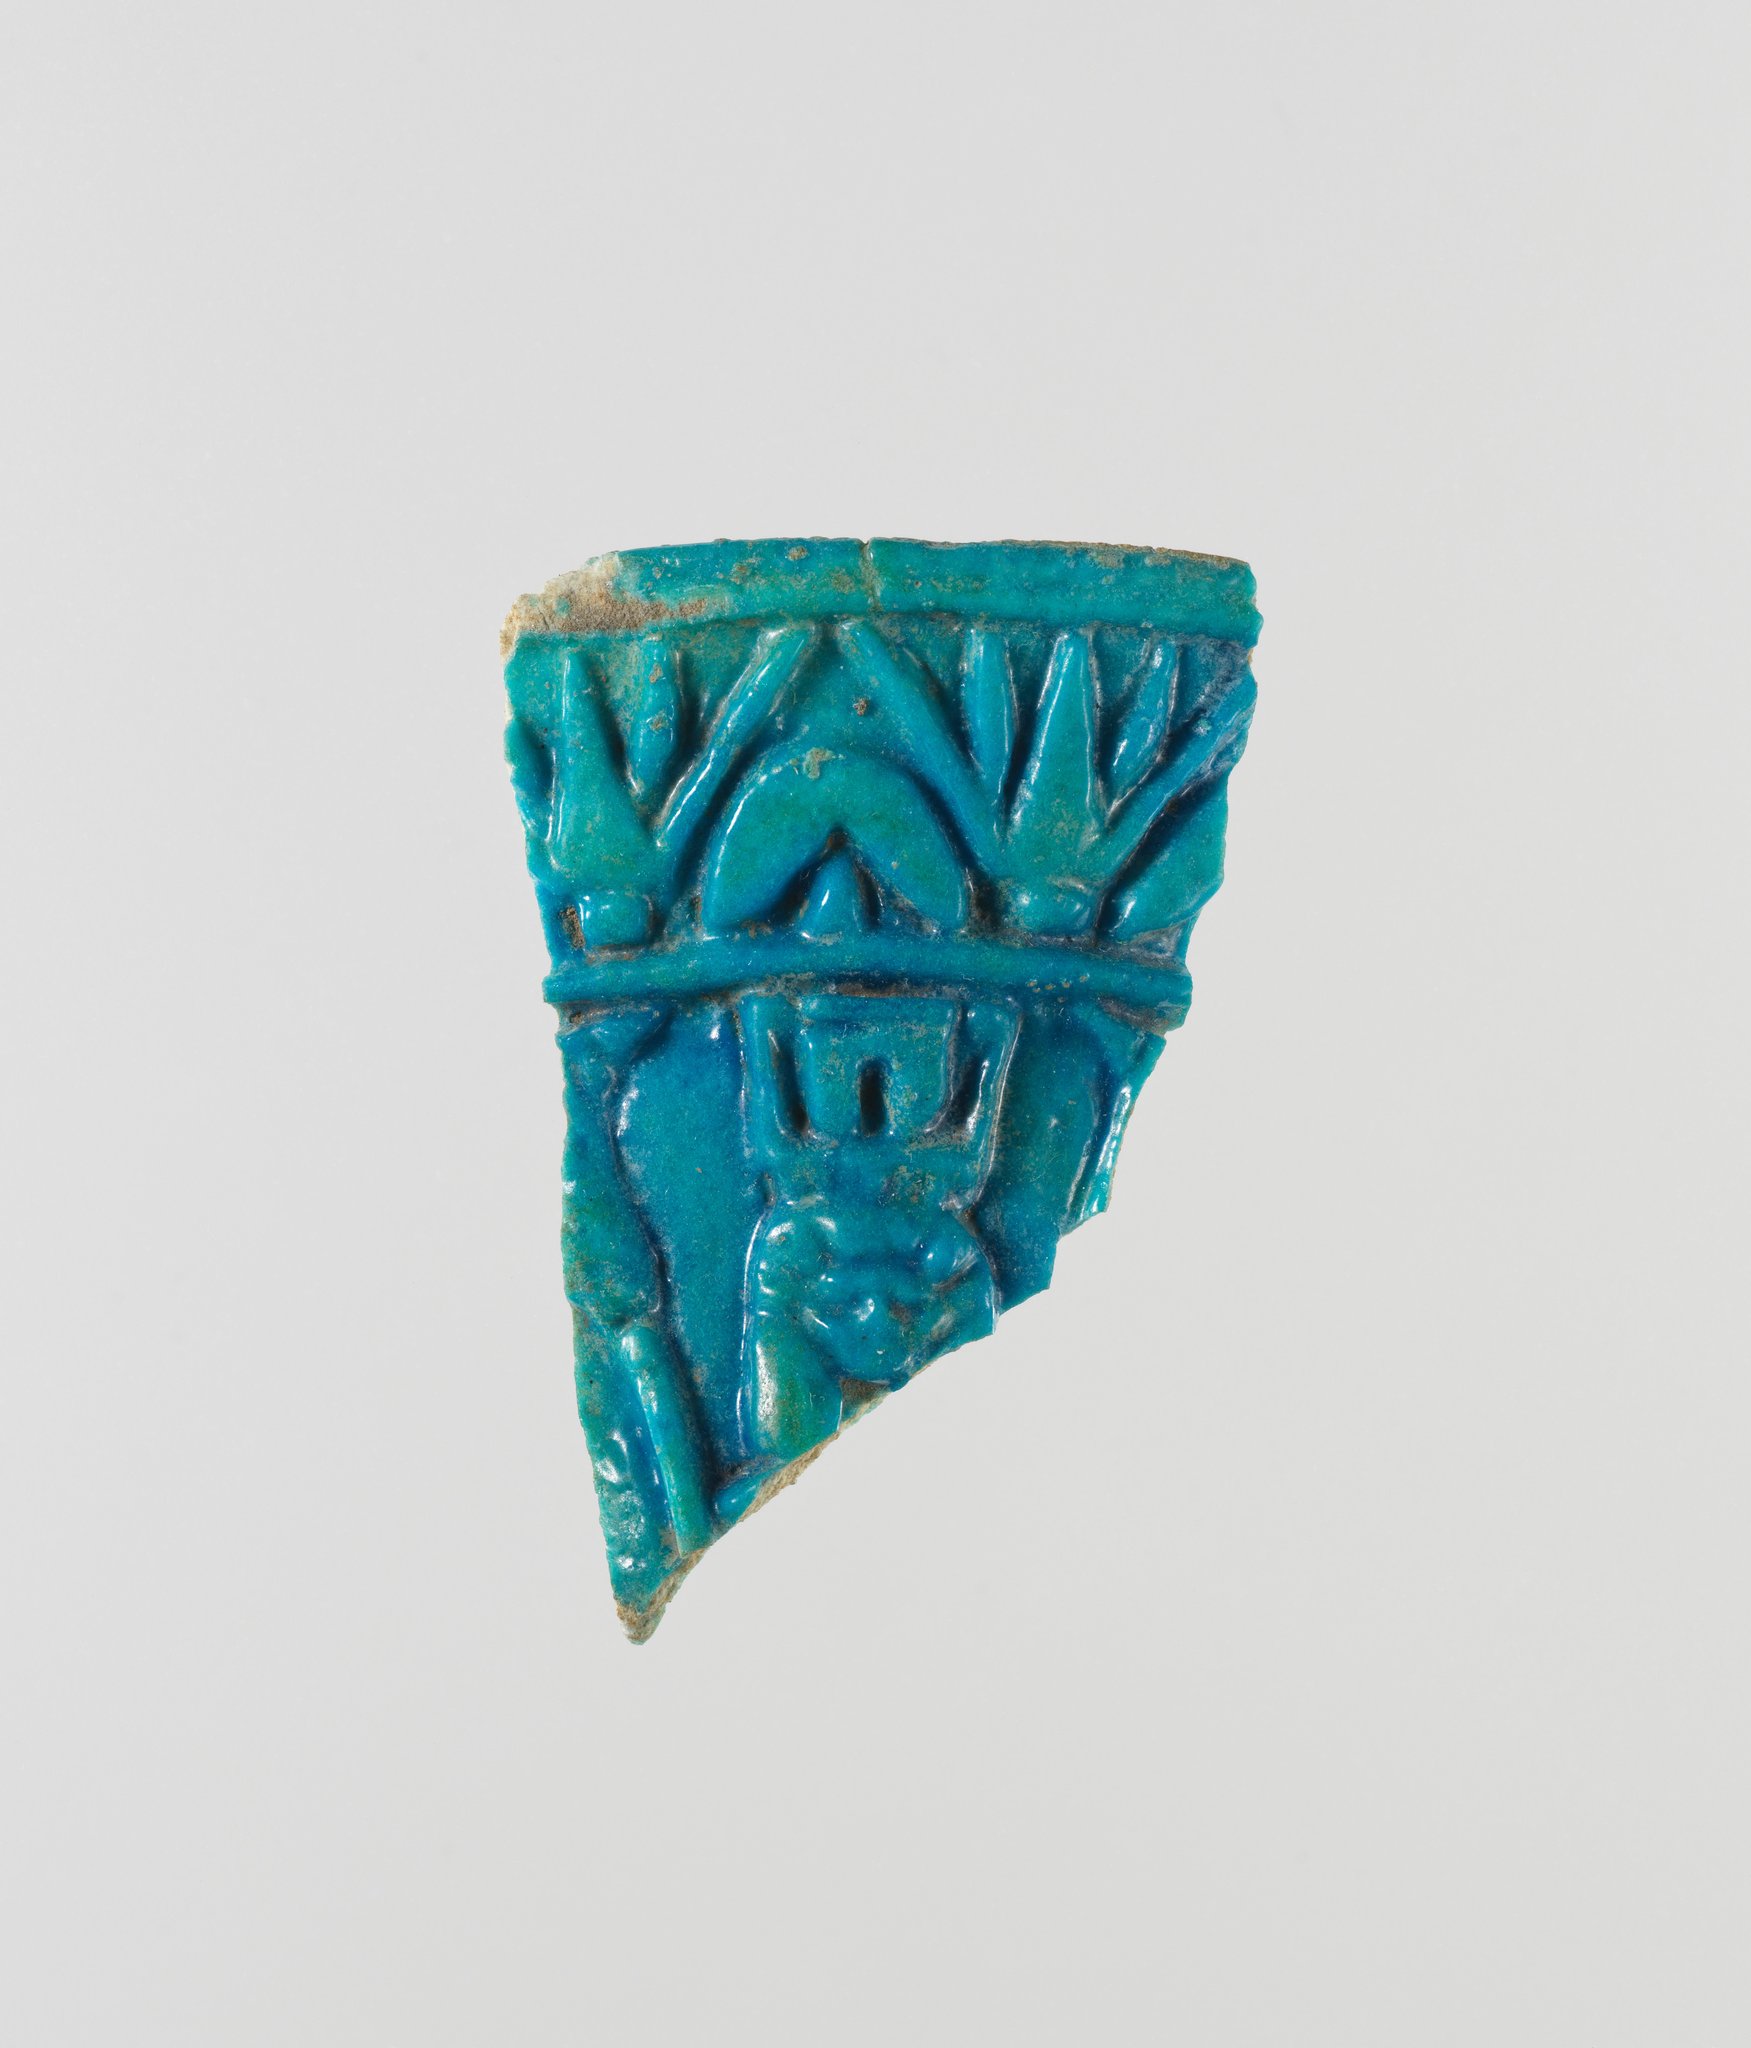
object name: chalice, cup, lotiform, relief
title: Chalice fragment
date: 1070-664 BCE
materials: faience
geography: egypt